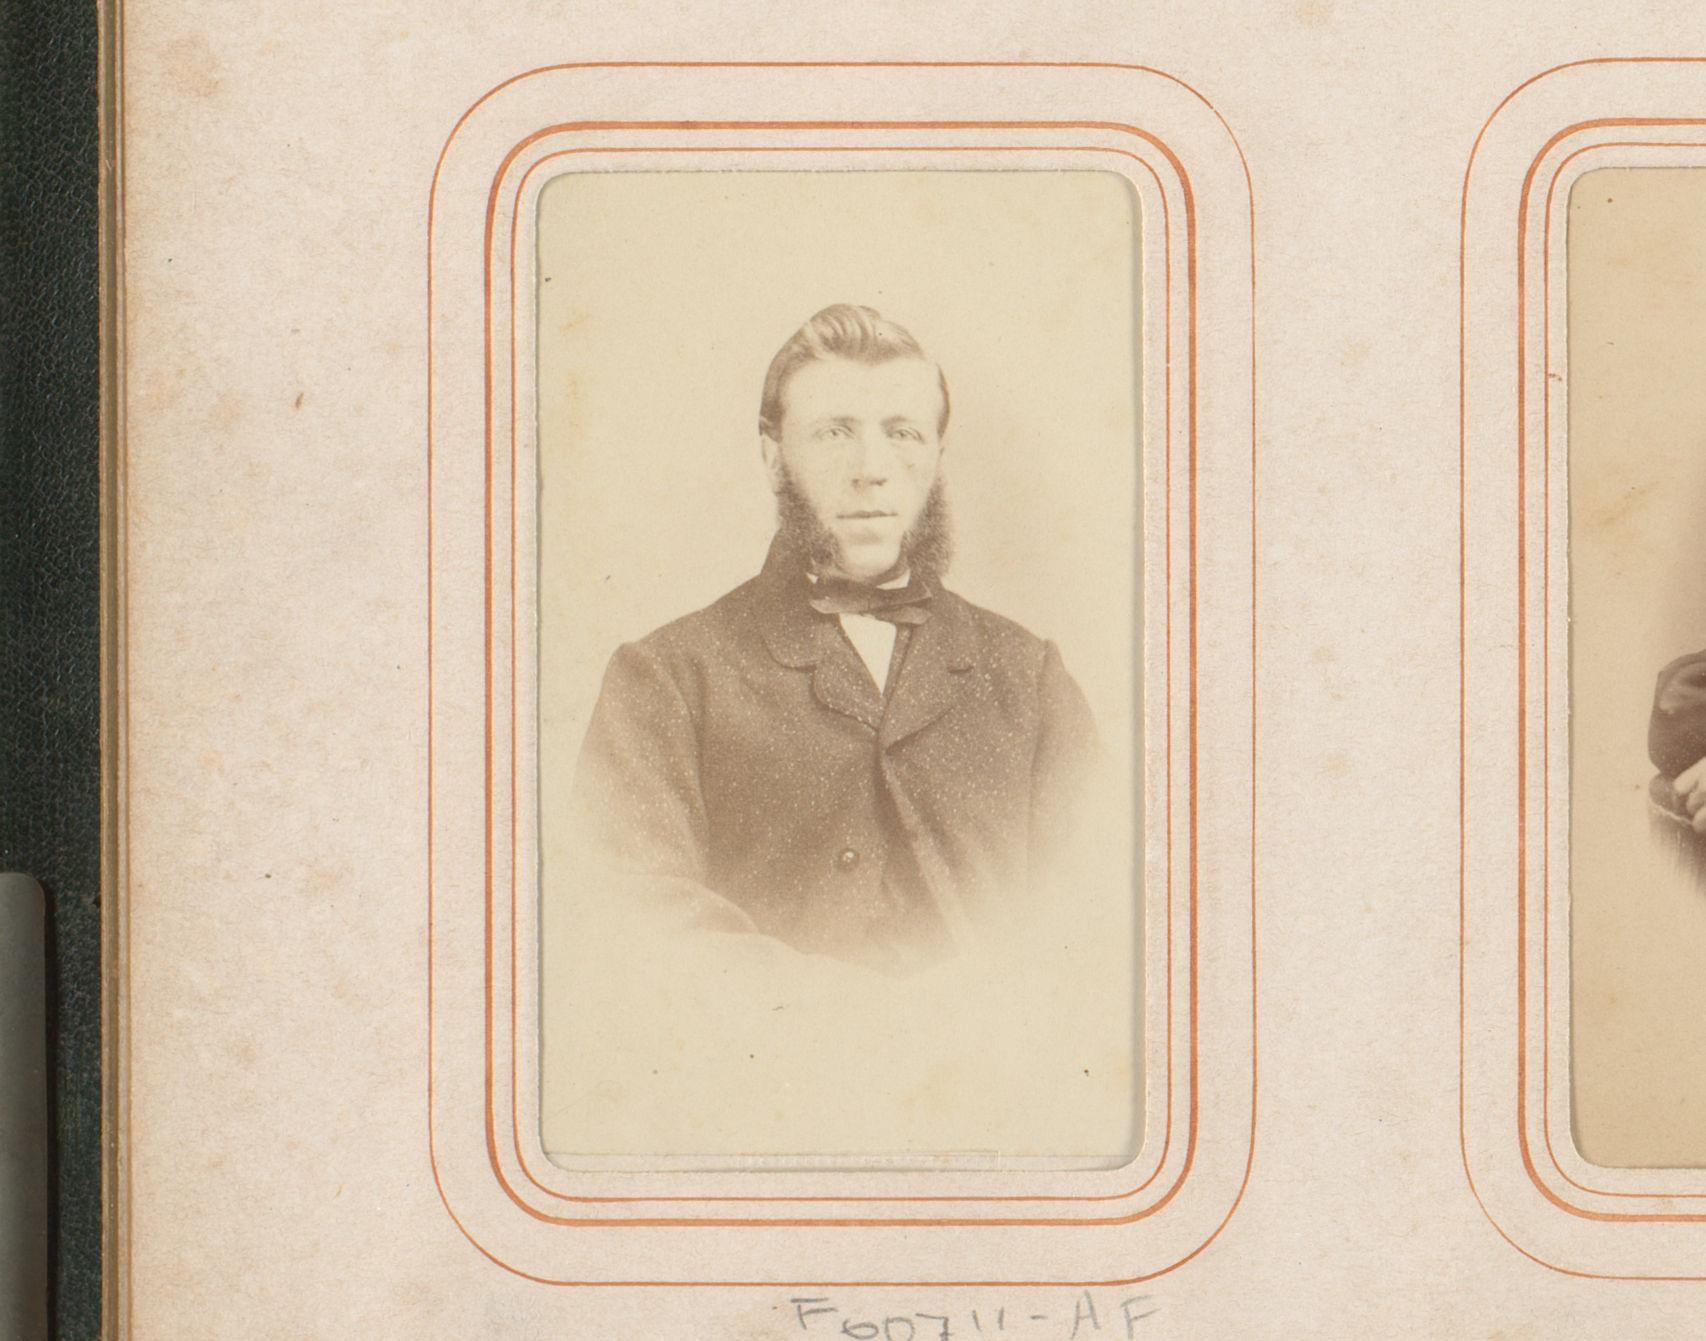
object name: album leaf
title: Portret van een man met bakkebaarden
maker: frederik harting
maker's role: fotograaf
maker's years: 1835-1902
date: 1863-1899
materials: cardboard, photographic support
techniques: albumen print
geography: gouda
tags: sideburns, historical persons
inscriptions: inscription: ‘F. Harting/ Photographe/ Gouda’